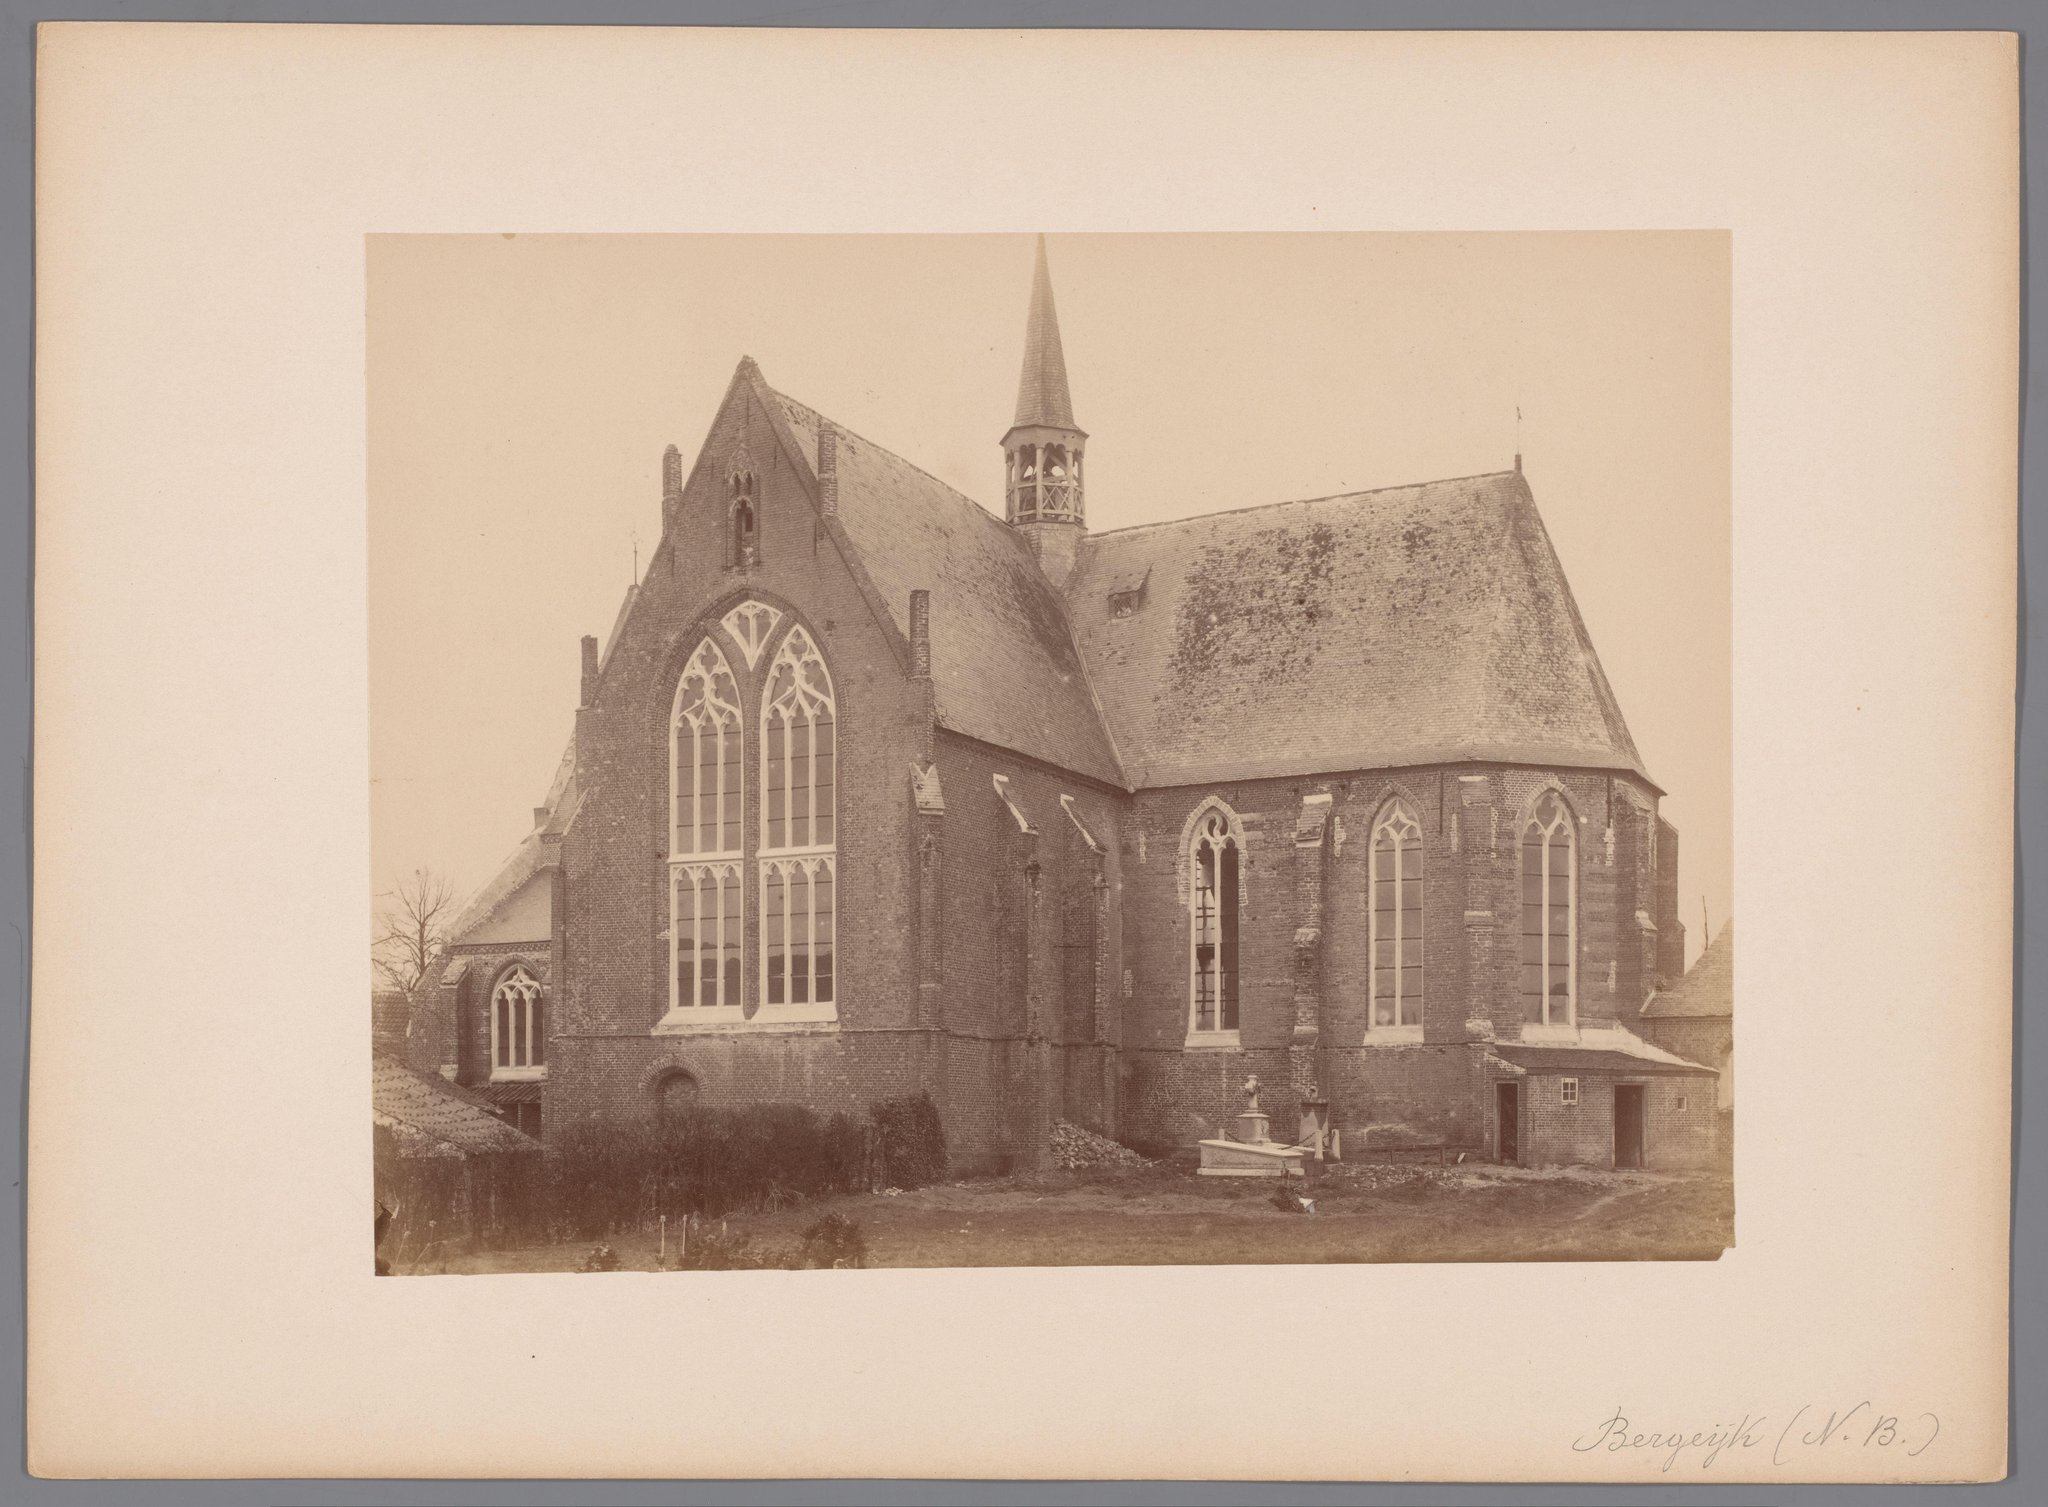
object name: photograph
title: Zuidzijde van St. Petrus' Bandenkerk of Hofkerk te Bergeijk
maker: anoniem (monumentenzorg)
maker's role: fotograaf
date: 1890-1920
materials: cardboard, photographic support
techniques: albumen print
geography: bergeijk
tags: church (exterior)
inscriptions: annotation: ‘Bergeijk (N.B.)’, annotation: ‘Bergeijk N.B./ Zuidzijde kerk’